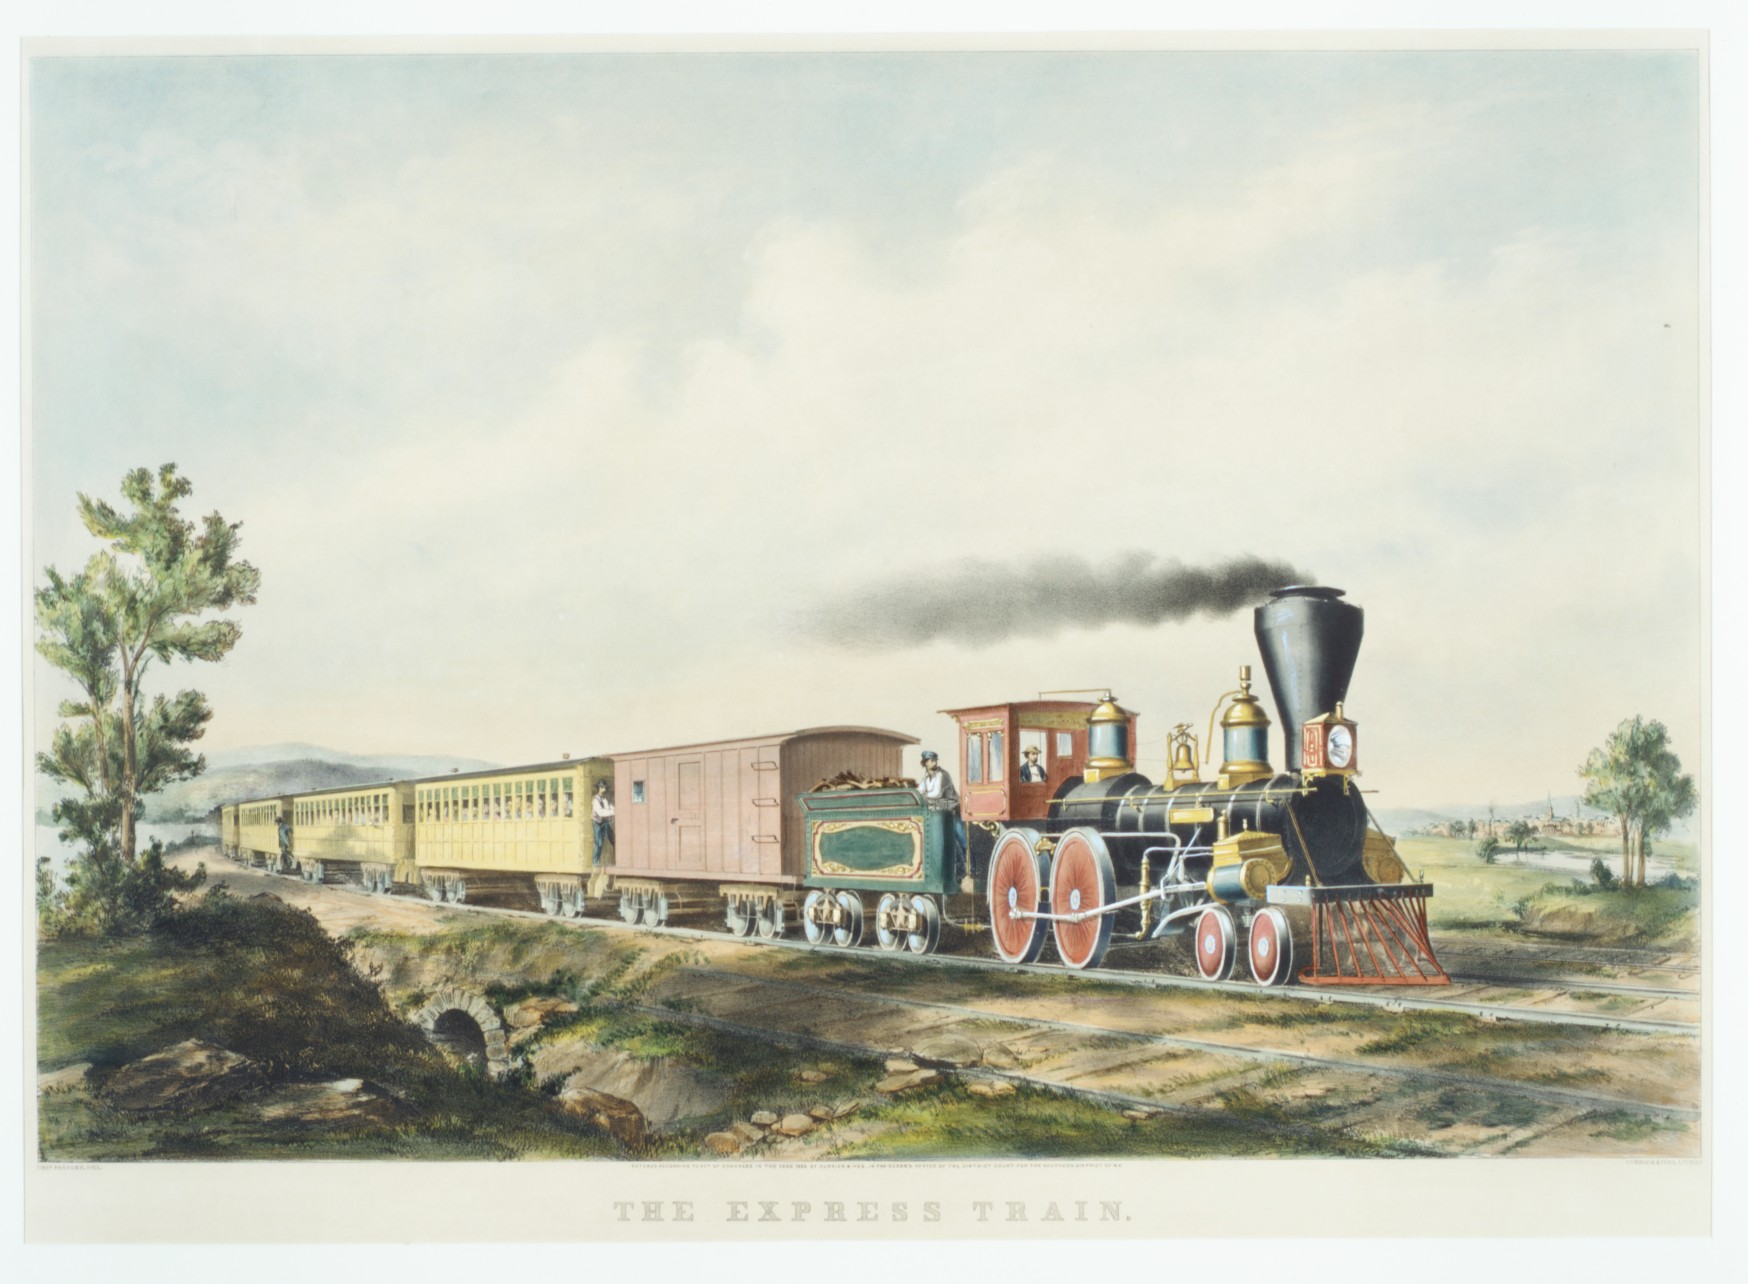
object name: print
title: The Express Train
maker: charles parsons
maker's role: artist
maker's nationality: american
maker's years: 1821-1910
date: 1859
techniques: hand coloring, lithograph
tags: railways,trains